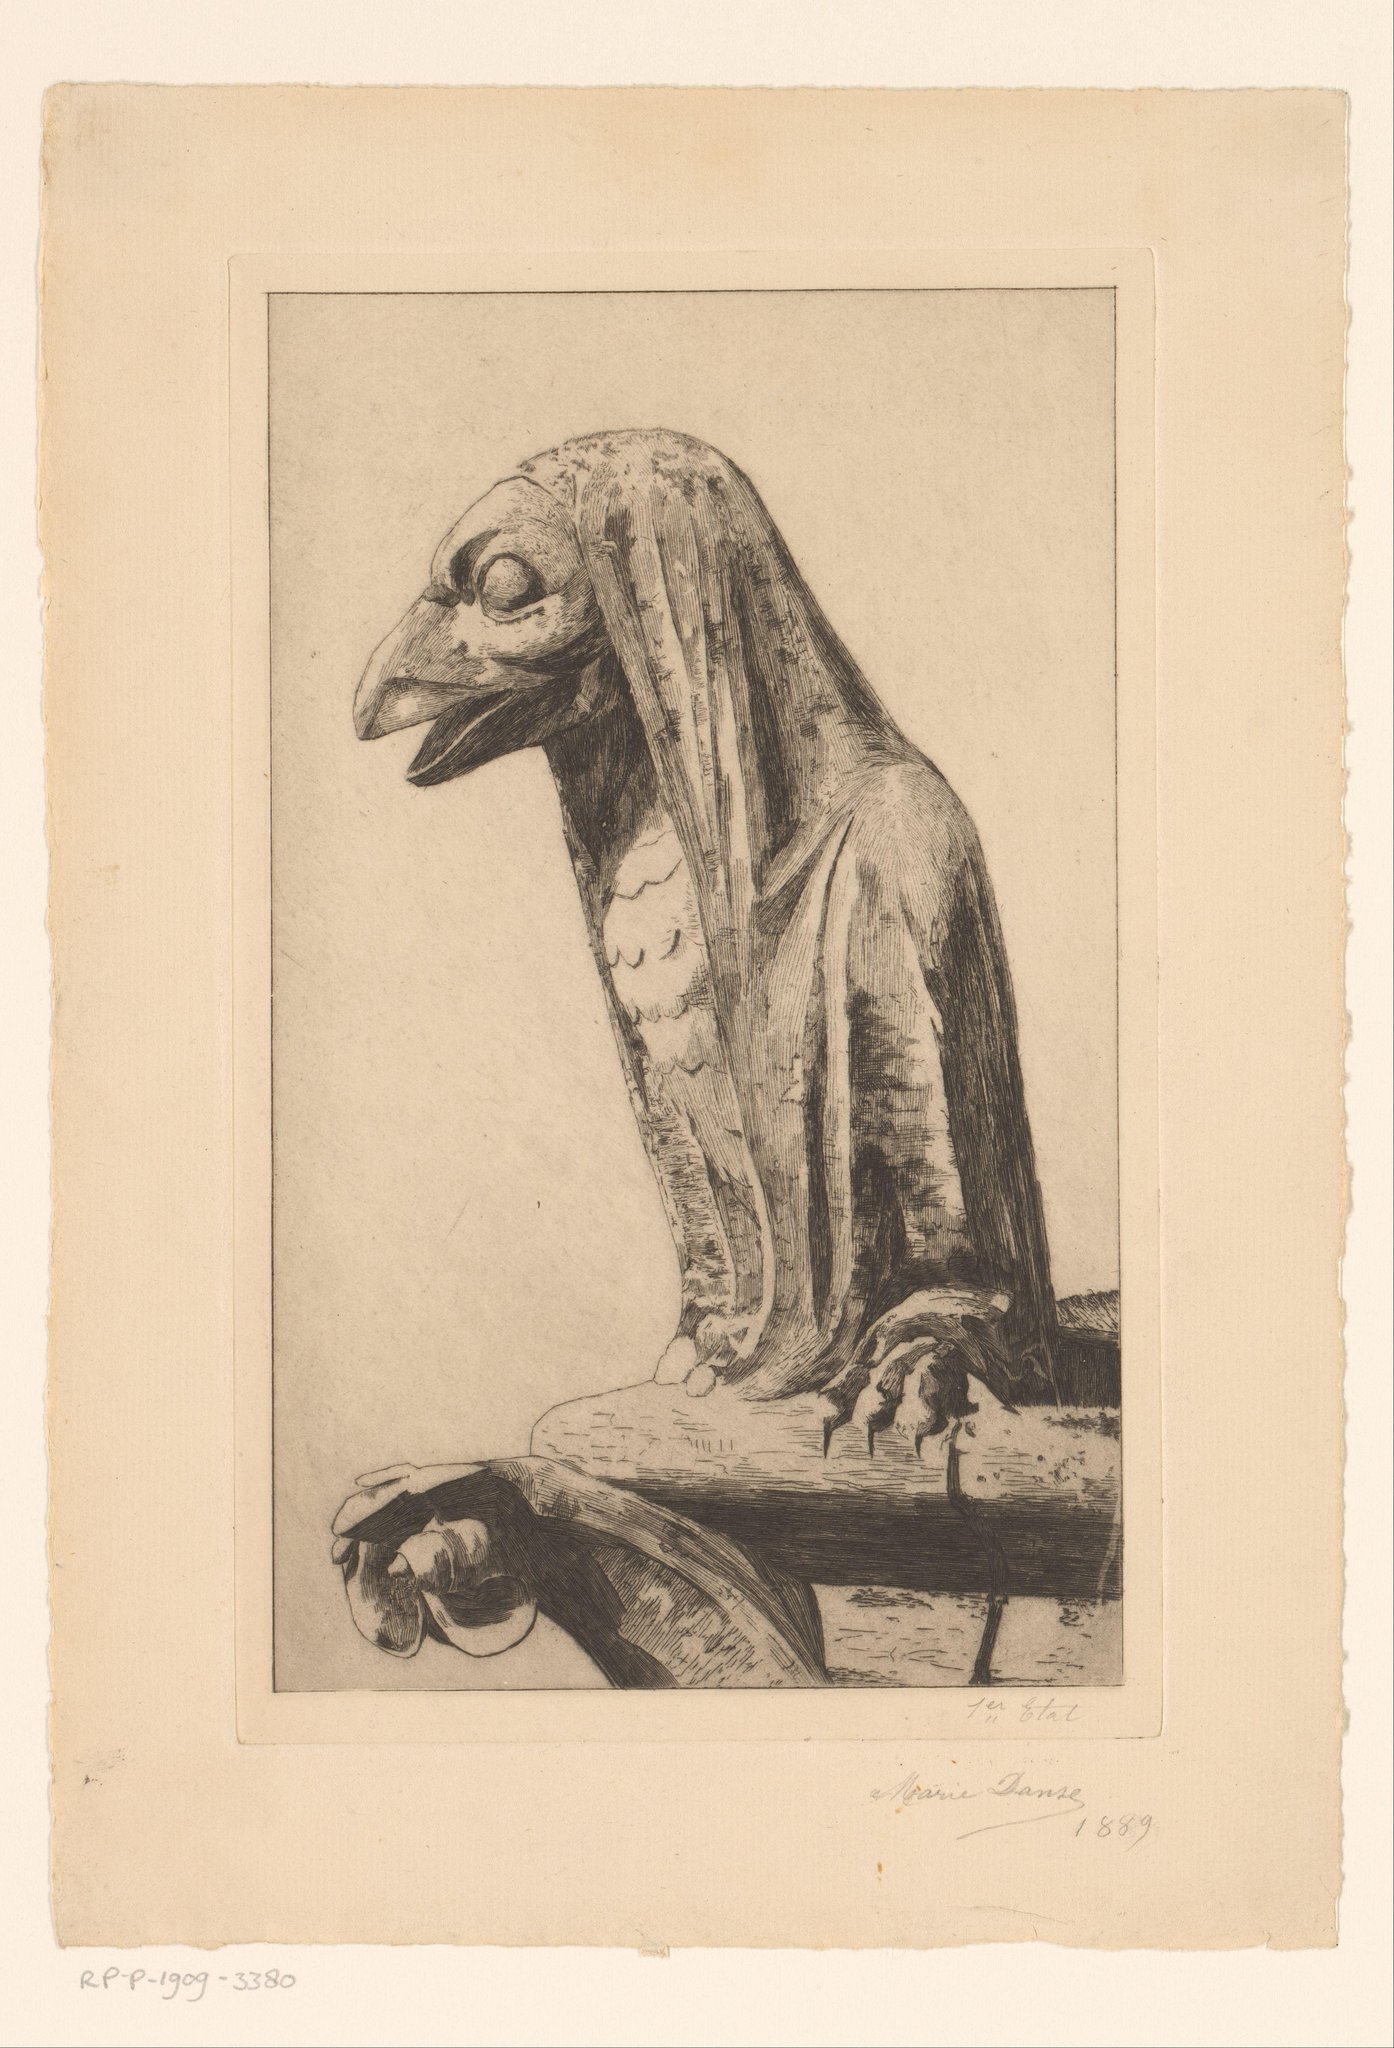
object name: print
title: Waterspuwer van de Notre-Dame te Parijs in de vorm van een vogel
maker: marie danse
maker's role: print maker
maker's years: 1867-1942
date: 1889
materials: paper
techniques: etching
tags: ornament ~ hybrid animals, piece of sculpture, reproduction of a piece of sculpture, parts of church exterior and annexes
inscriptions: collector's mark: Lugt 2228, inscription: ‘1er Etat’